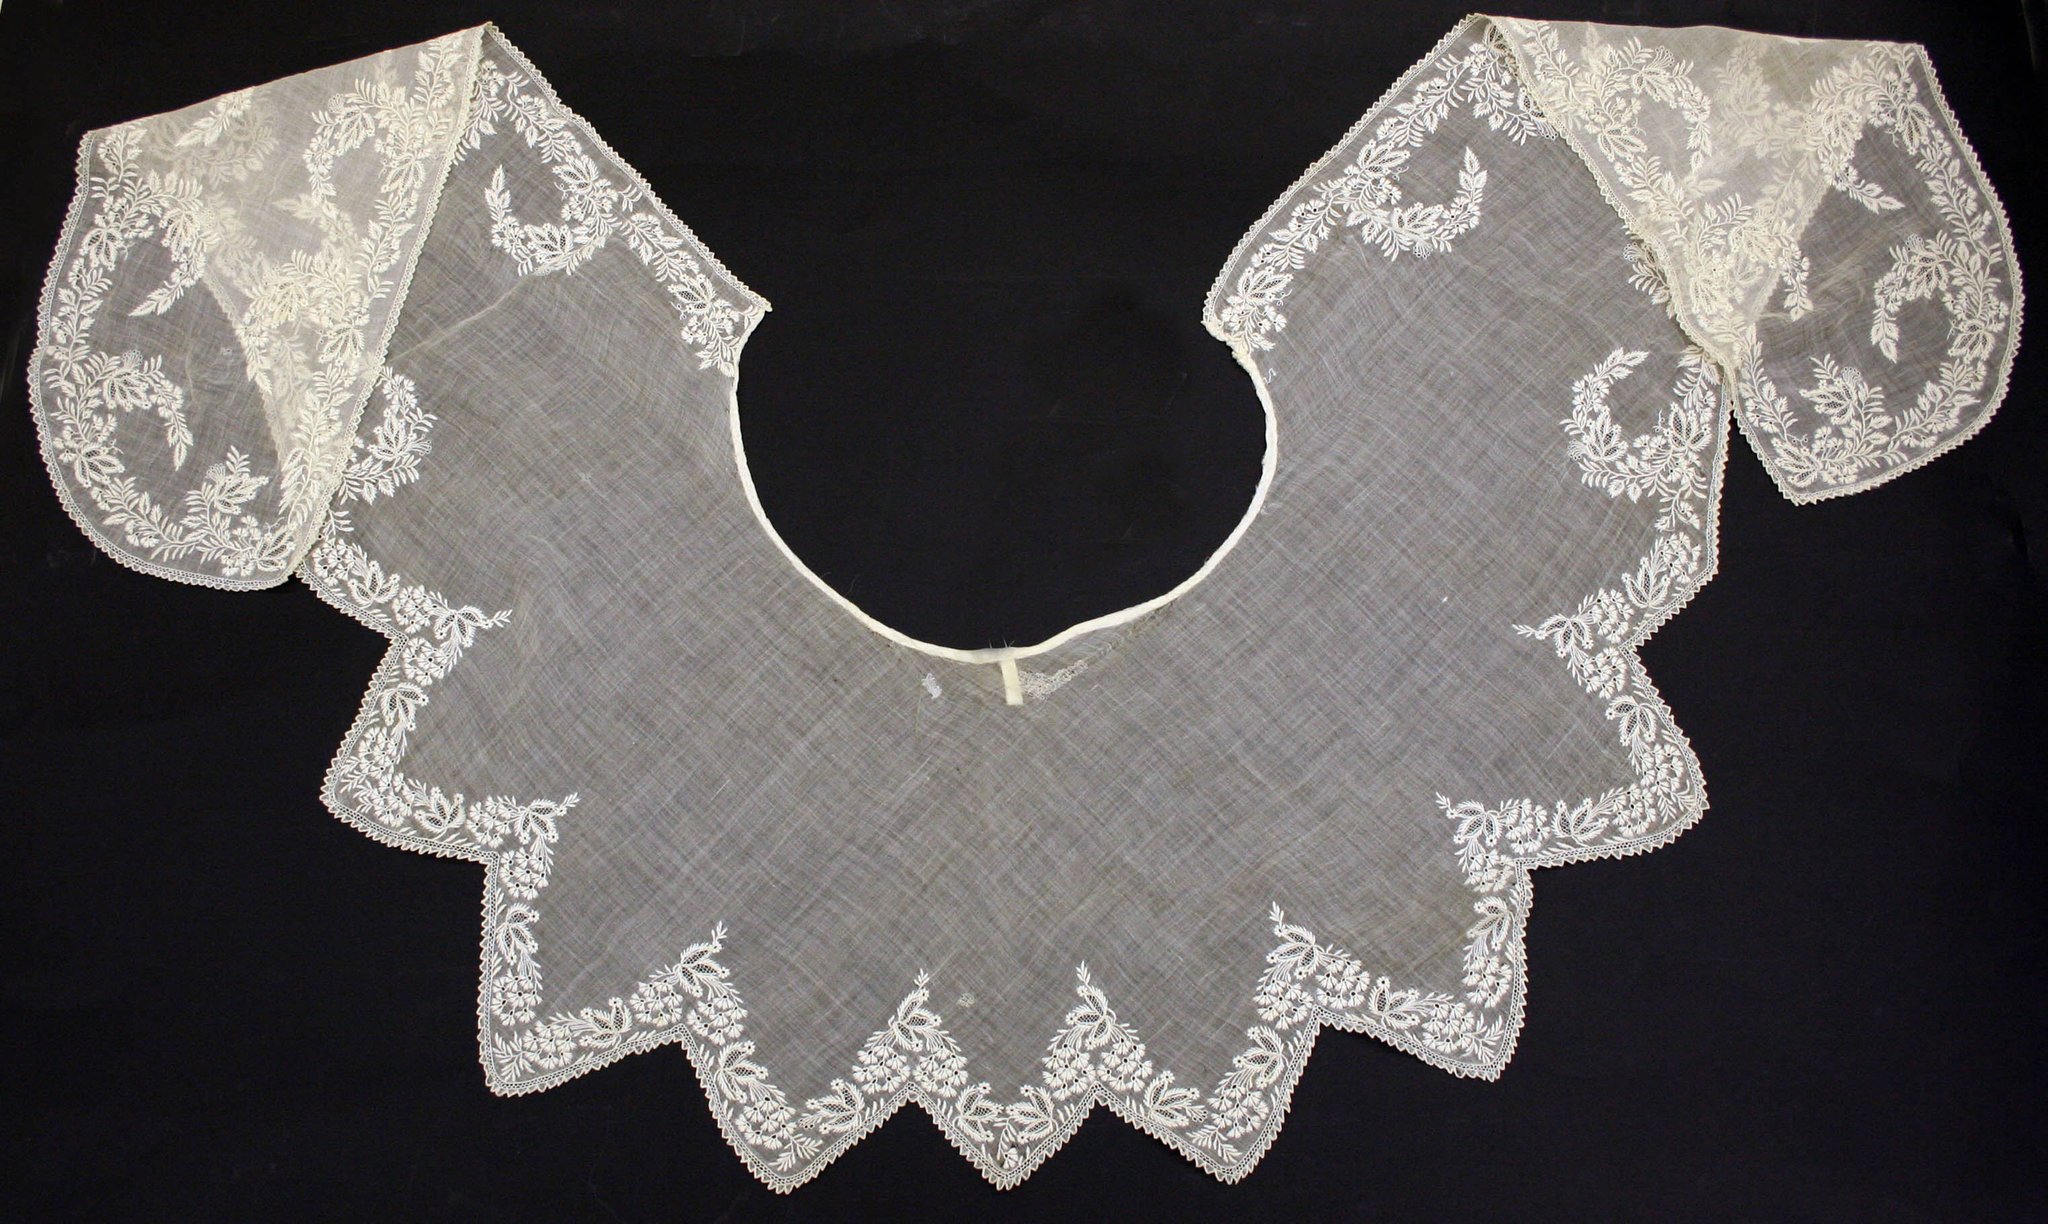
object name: fichu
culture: american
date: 1830-1839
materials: cotton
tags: flowers